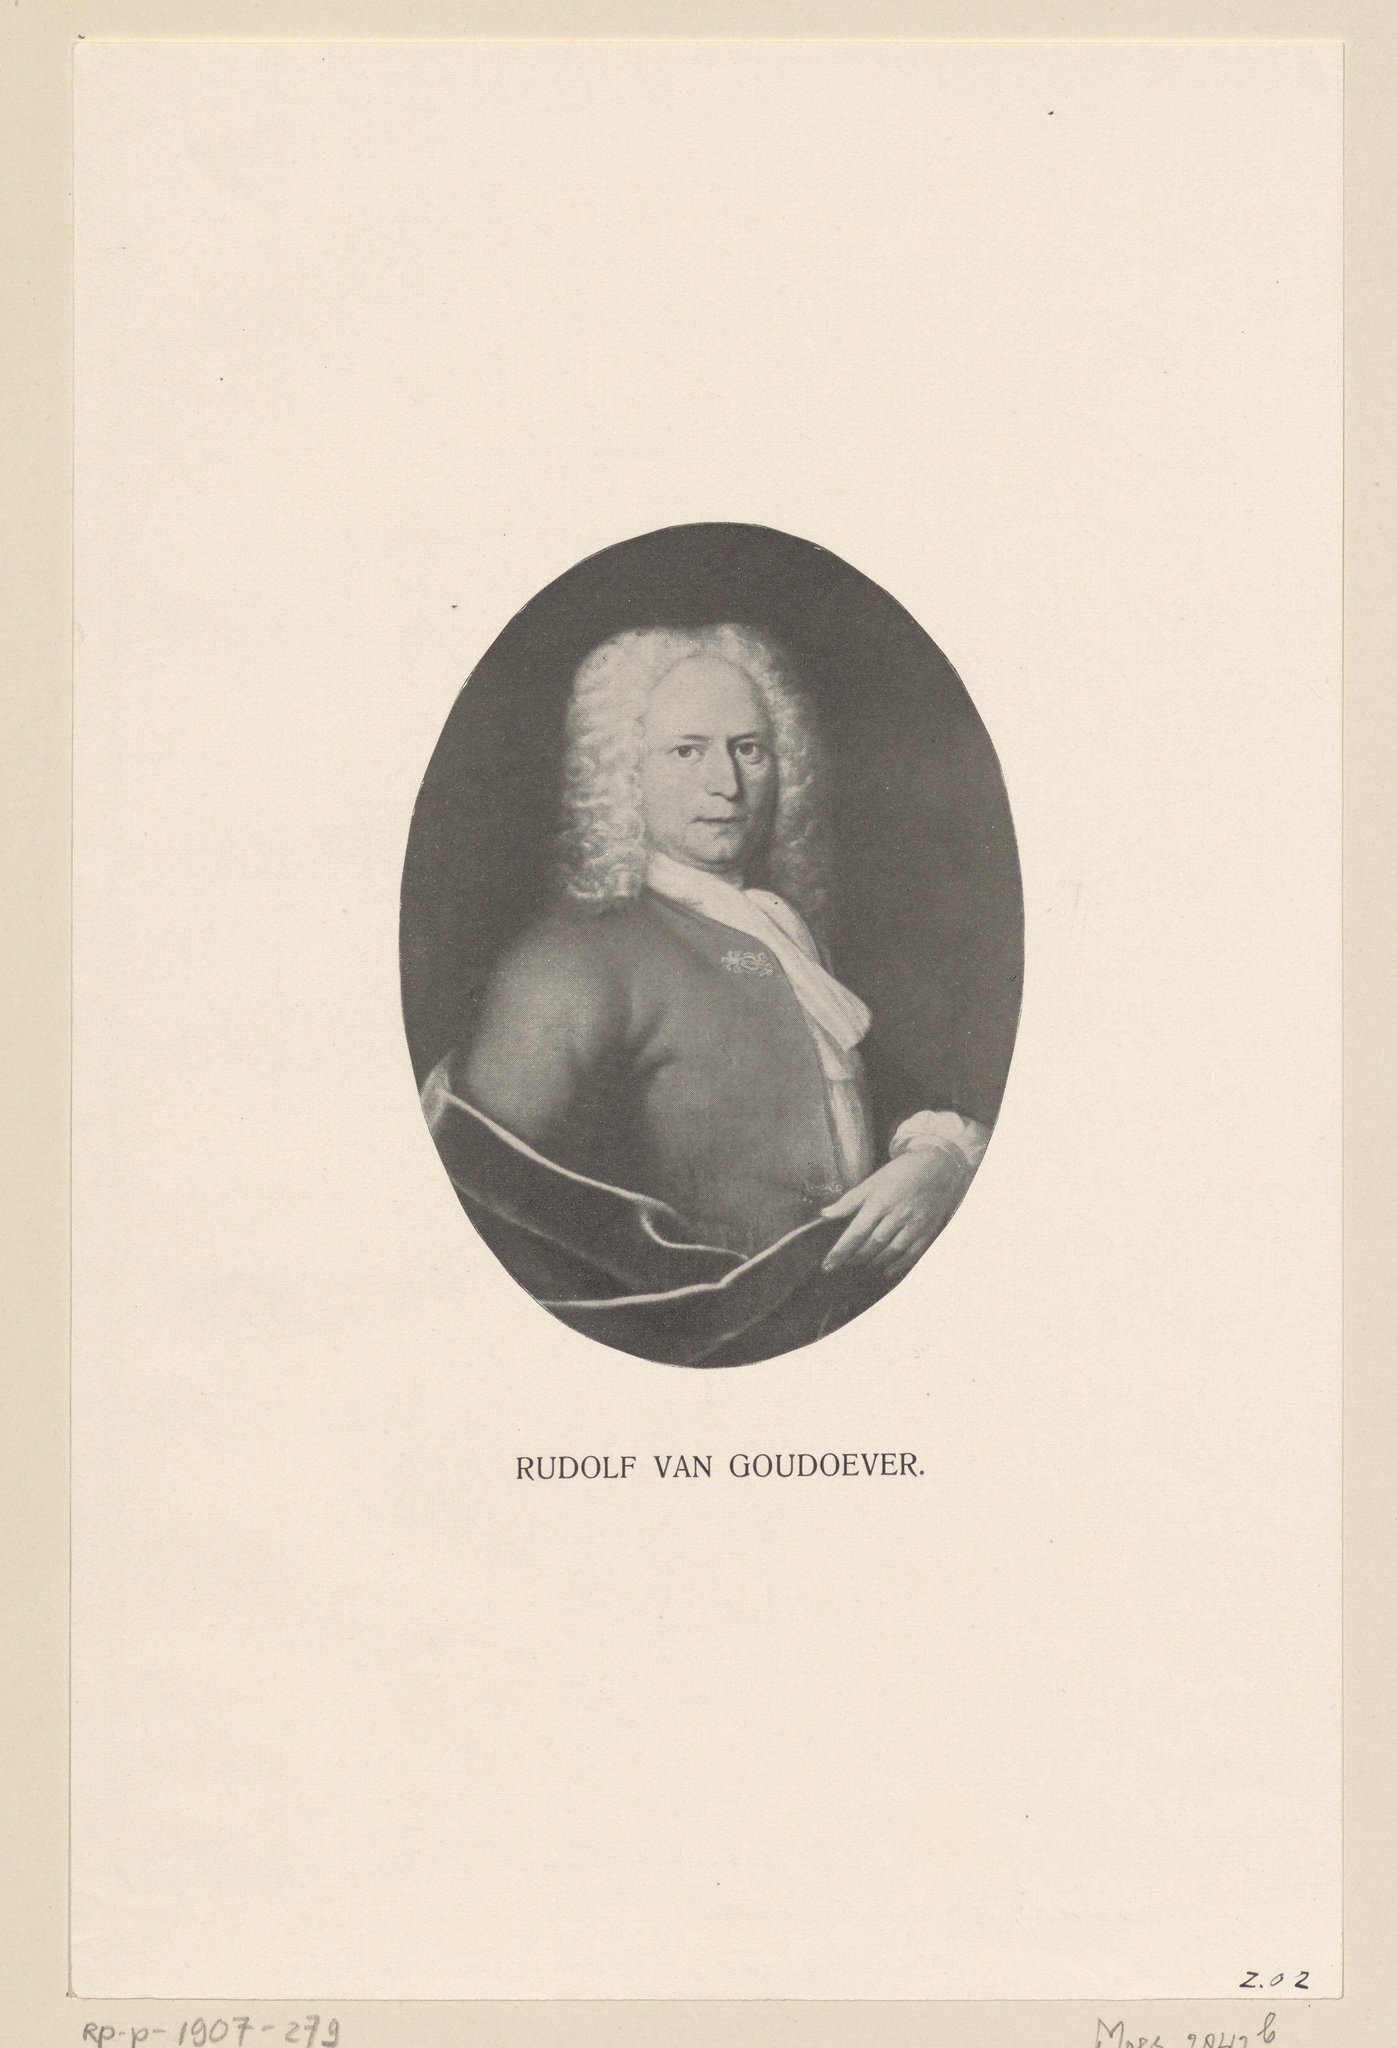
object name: reproduction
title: Portret van Rudolf van Goudoever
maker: Anonymous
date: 1895-1950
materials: paper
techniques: letterpress printing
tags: historical persons, nobility and patriciate; chivalry, knighthood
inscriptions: collector's mark: Lugt 2228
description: Prent uit dezelfde (onbekende) publicatie als RP-R-1907-275 en RP-R-1907-278 in de collectie van het Rijksmuseum Amsterdam.